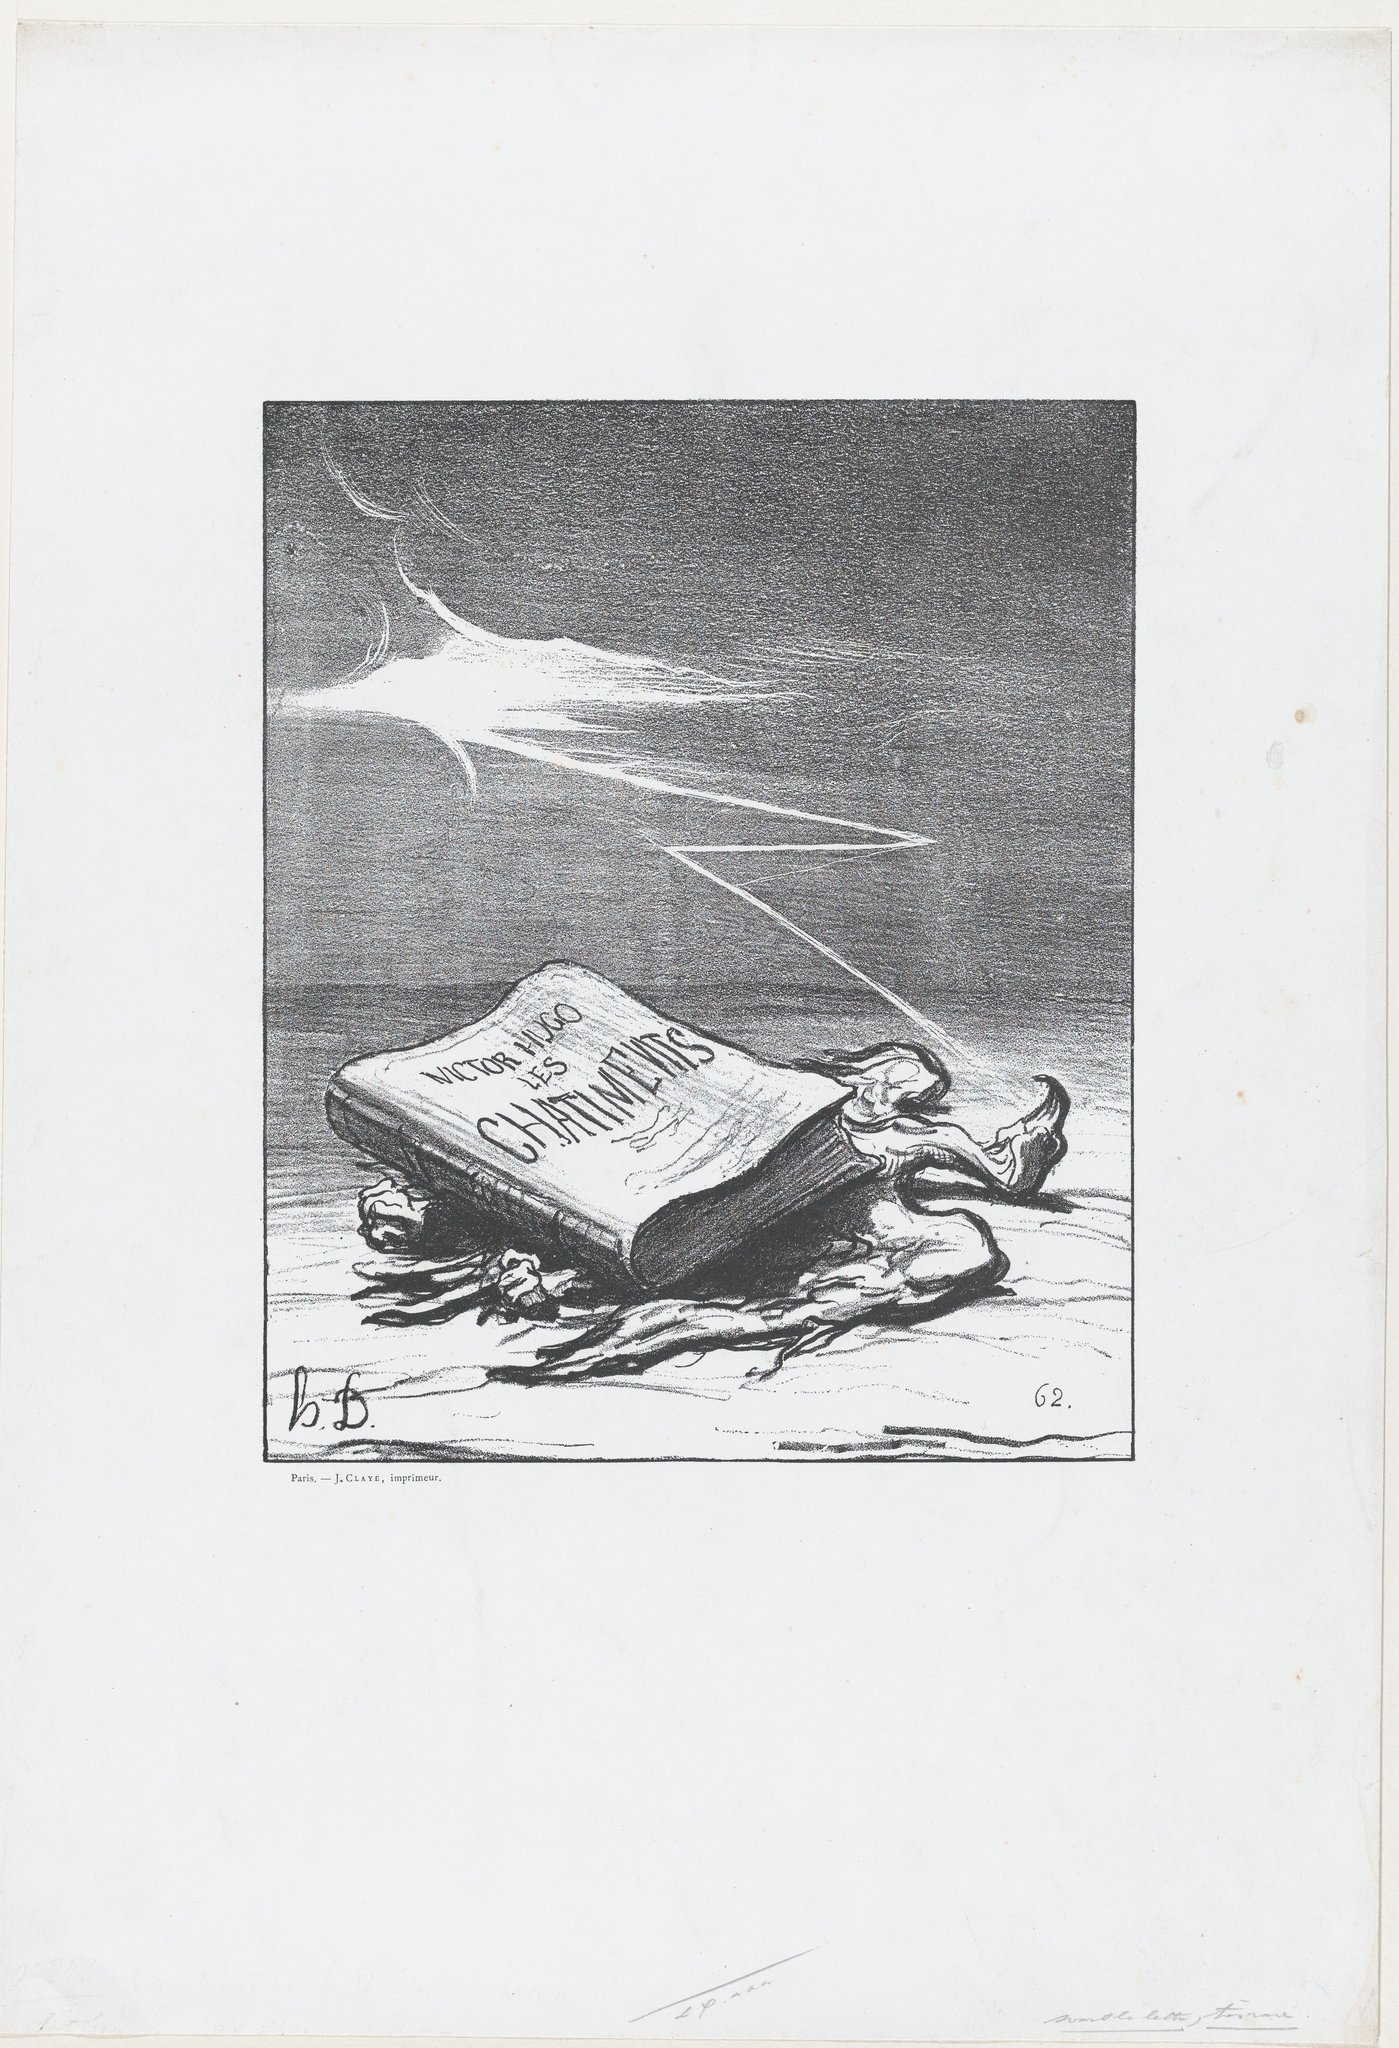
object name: print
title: A page from history, from 'News of the day,' published in Le Charivari, November 16, 1870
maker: honoré daumier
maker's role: artist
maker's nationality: french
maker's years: 1808-1879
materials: paper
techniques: lithograph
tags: eagles,satire,books